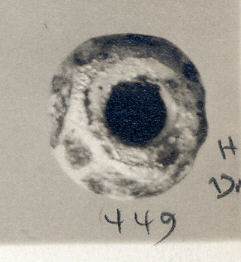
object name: bottle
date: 701-1000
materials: glass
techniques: cutting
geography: iran